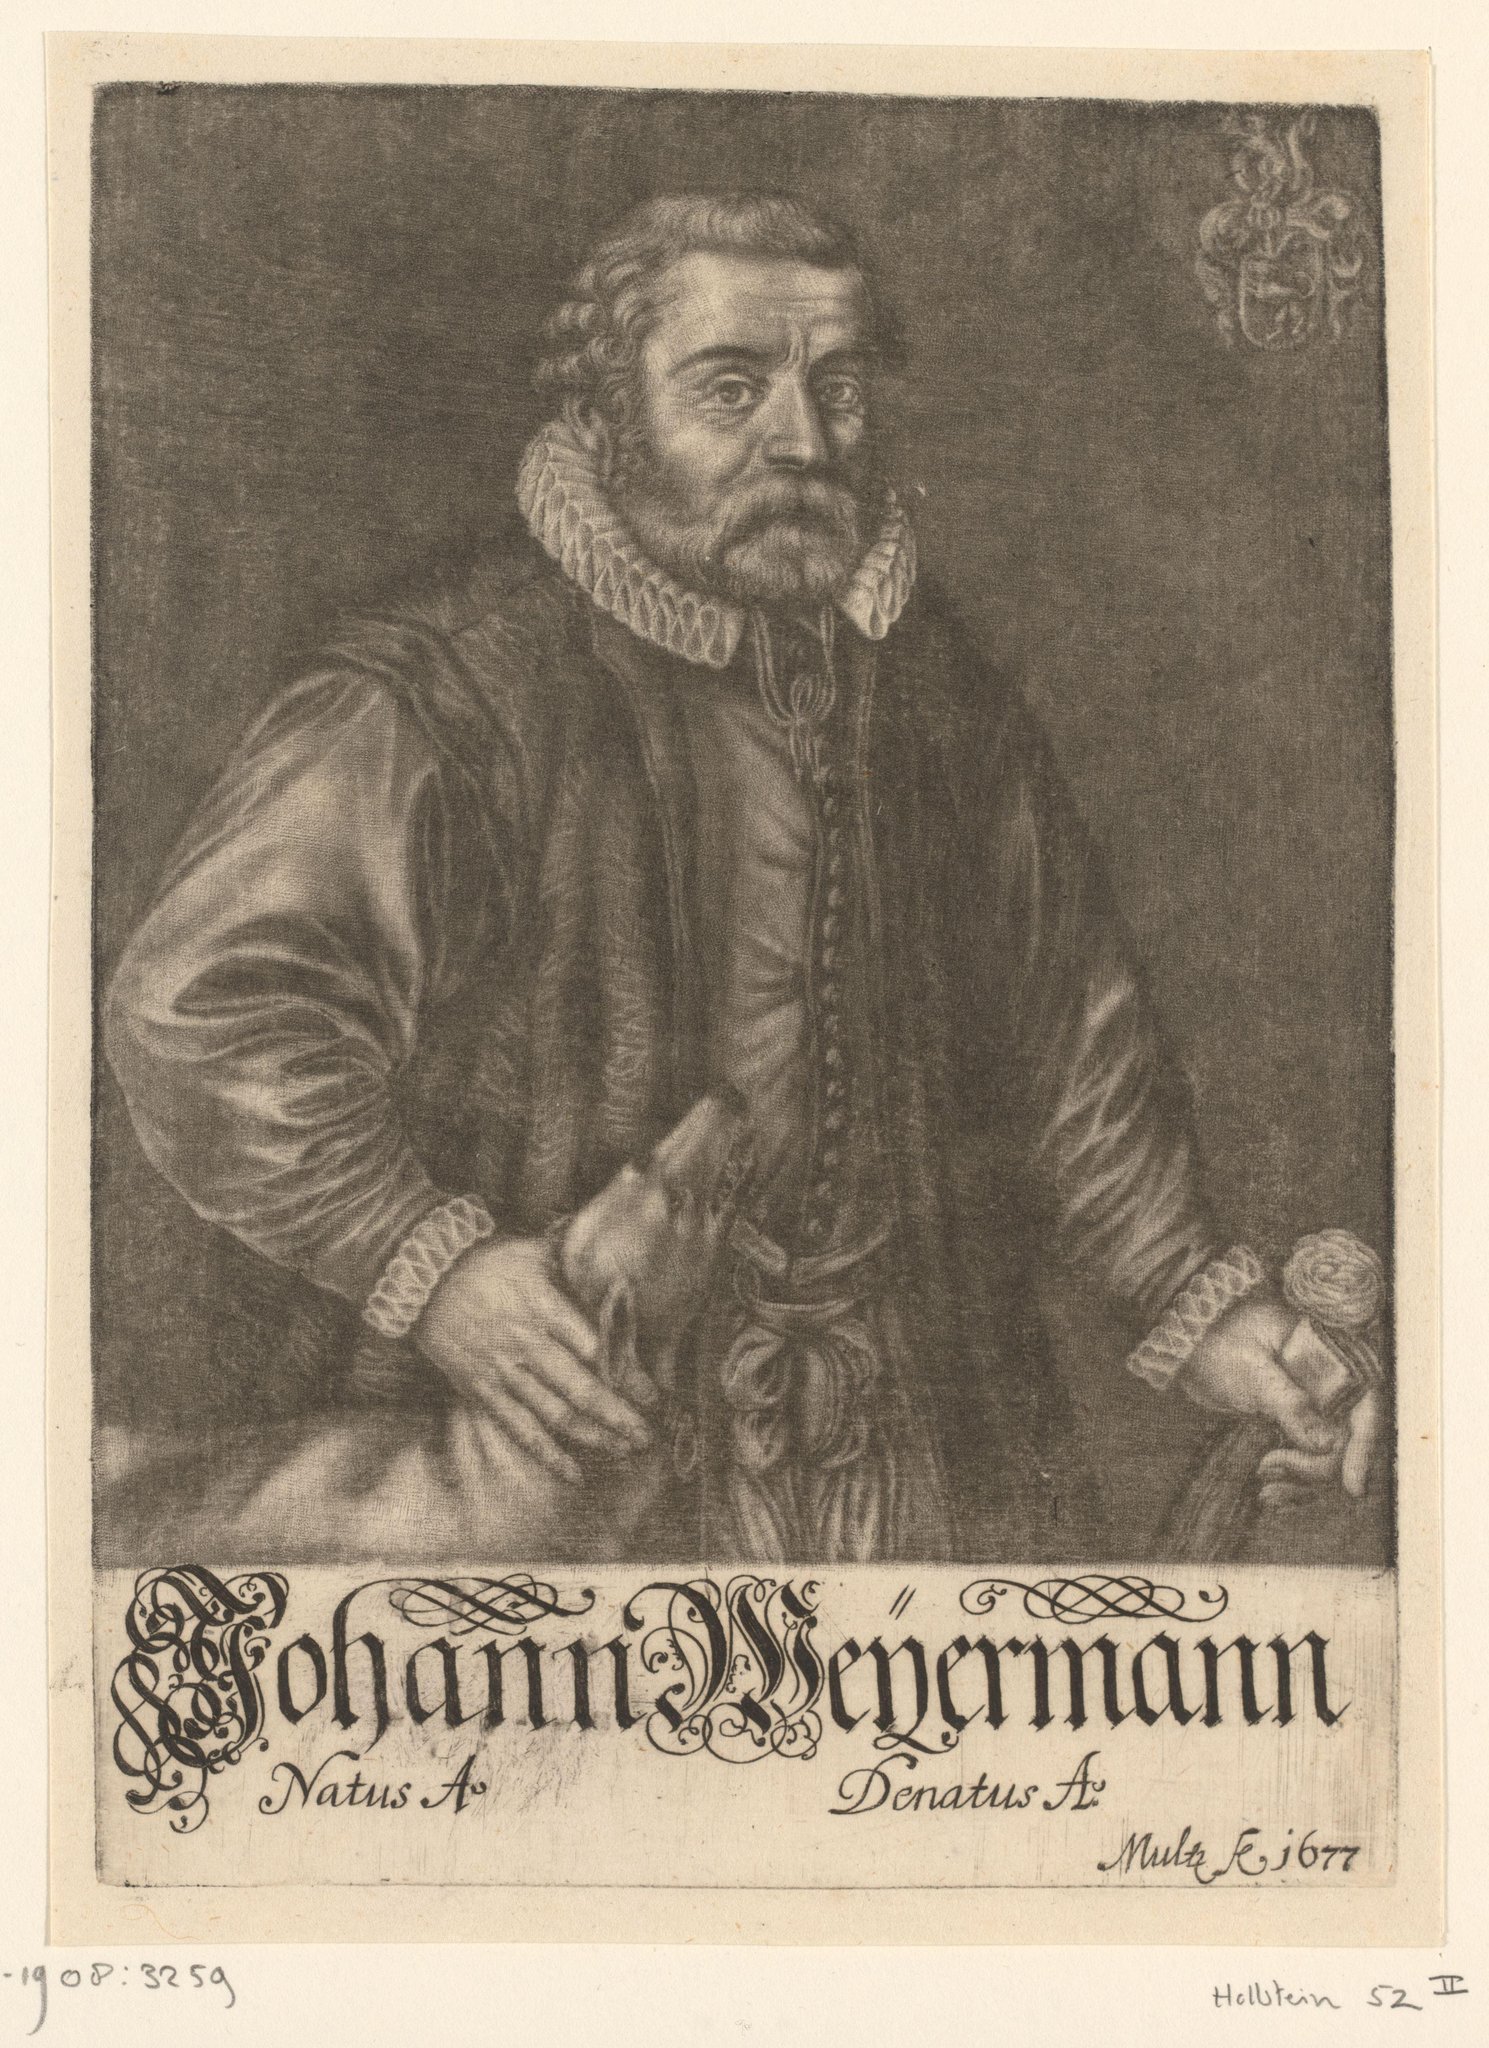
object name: print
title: Portret van Johann Weyermann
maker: andreas paul multz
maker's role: draughtsman, painter, print maker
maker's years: 1643-1695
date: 1677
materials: paper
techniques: mezzotint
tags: historical persons, armorial bearing, heraldry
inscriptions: collector's mark: Lugt 2228